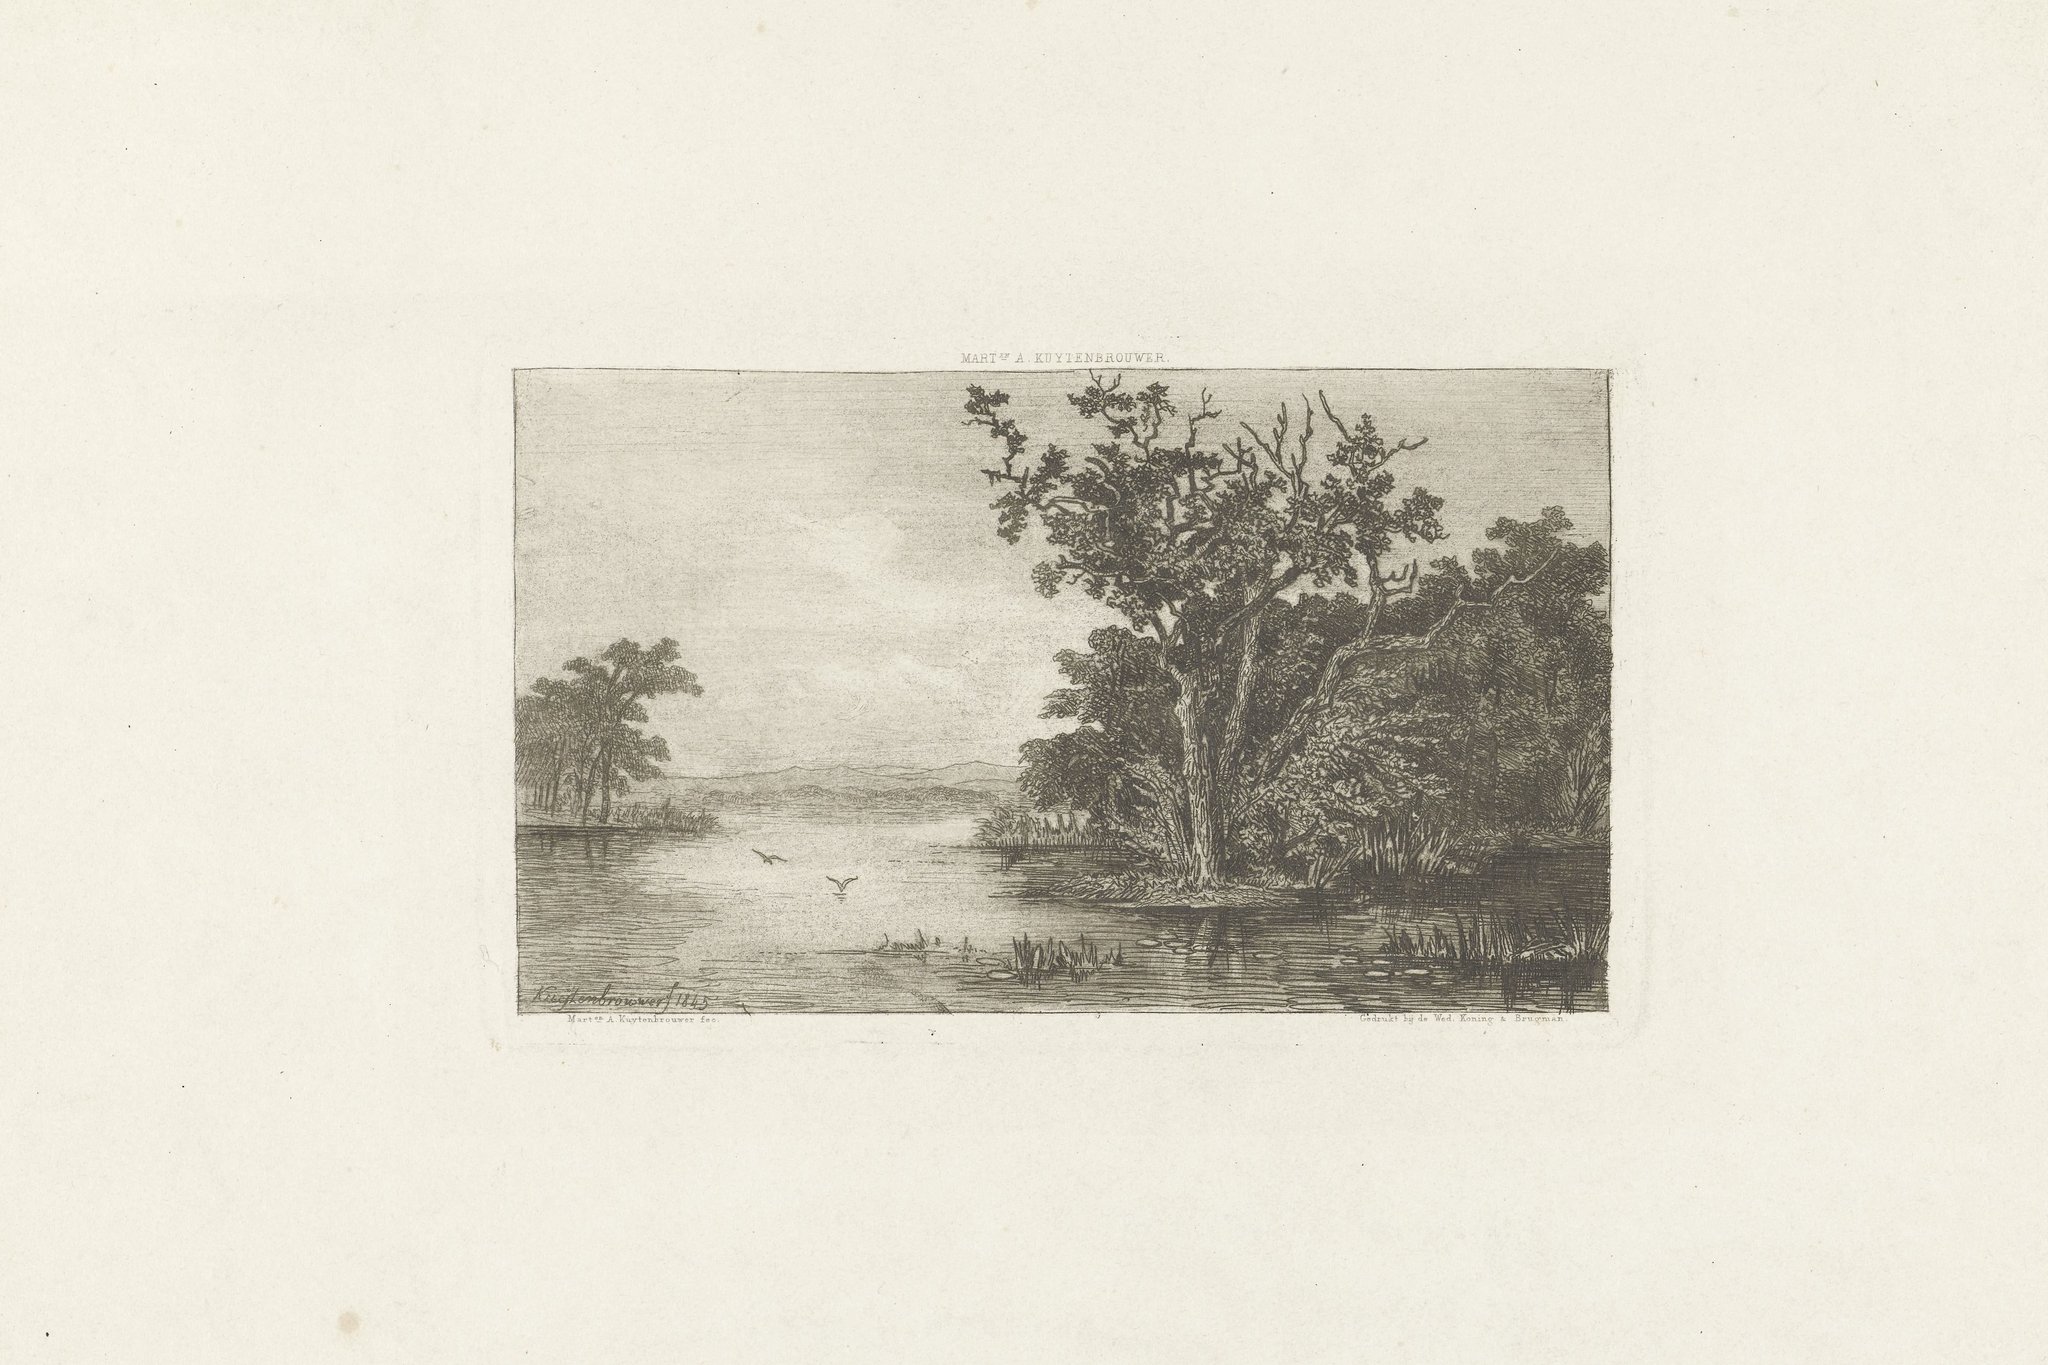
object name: print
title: Gezicht op een bosmeer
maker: martinus antonius kuytenbrouwer jr.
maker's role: draughtsman, painter, print maker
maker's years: 1821-1897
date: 1845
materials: paper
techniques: etching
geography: amsterdam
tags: birds, forest, wood, pond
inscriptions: inscription: ‘[...] Kuijtenbrouwer fec 1845 [...]’, collector's mark: Lugt 2228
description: Gezicht op een meer, aan de rand van een bos. Boven het meer twee vogels.